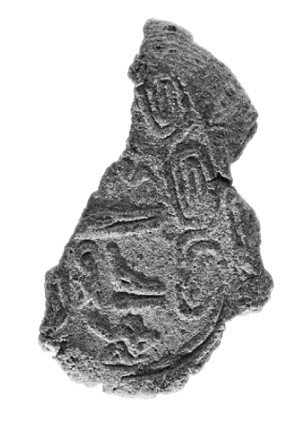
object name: sealing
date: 1981-1640 BCE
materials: mud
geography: egypt